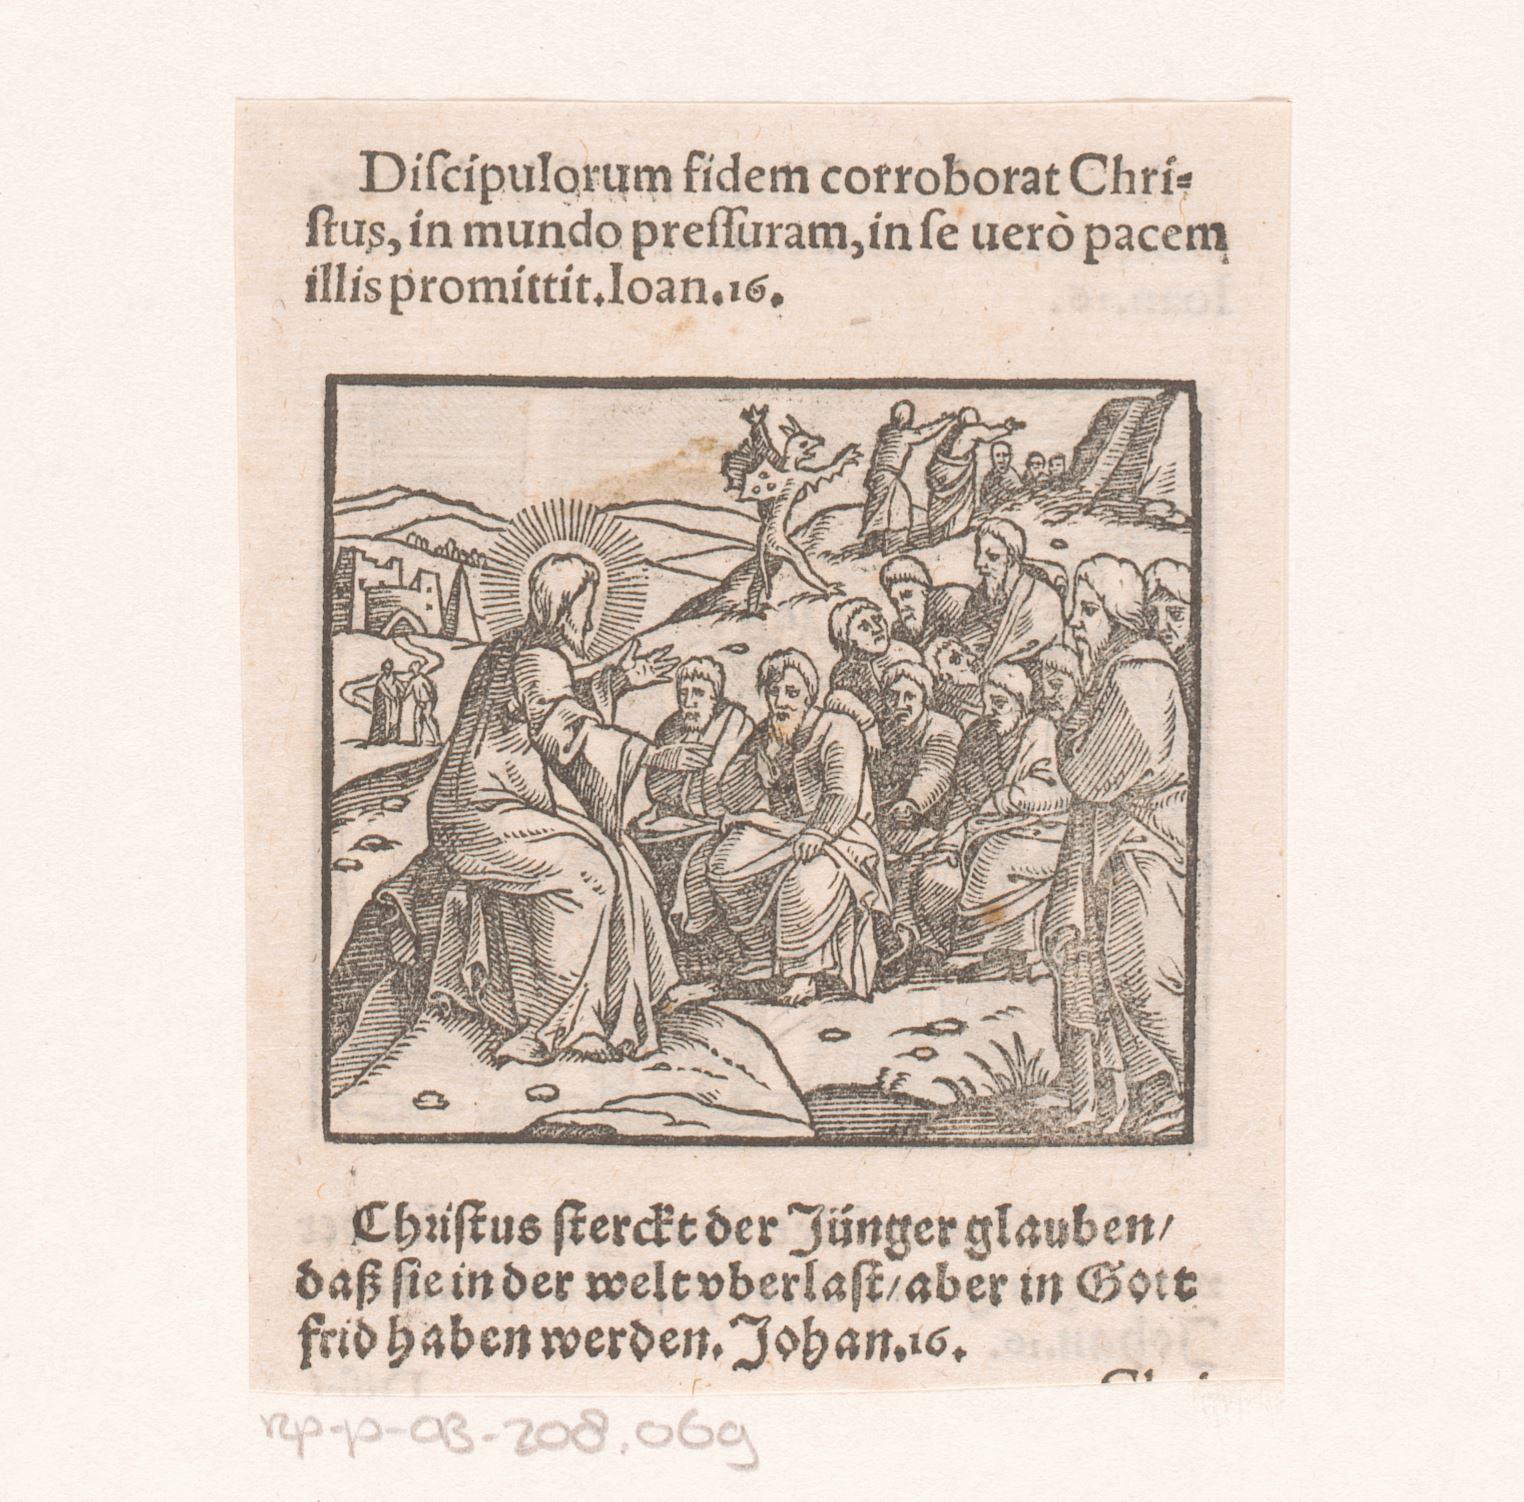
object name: print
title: Christus onderwijst zijn discipelen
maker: Anonymous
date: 1600-1699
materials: paper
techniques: letterpress printing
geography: netherlands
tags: christ explaining his doctrine to the apostles and disciples